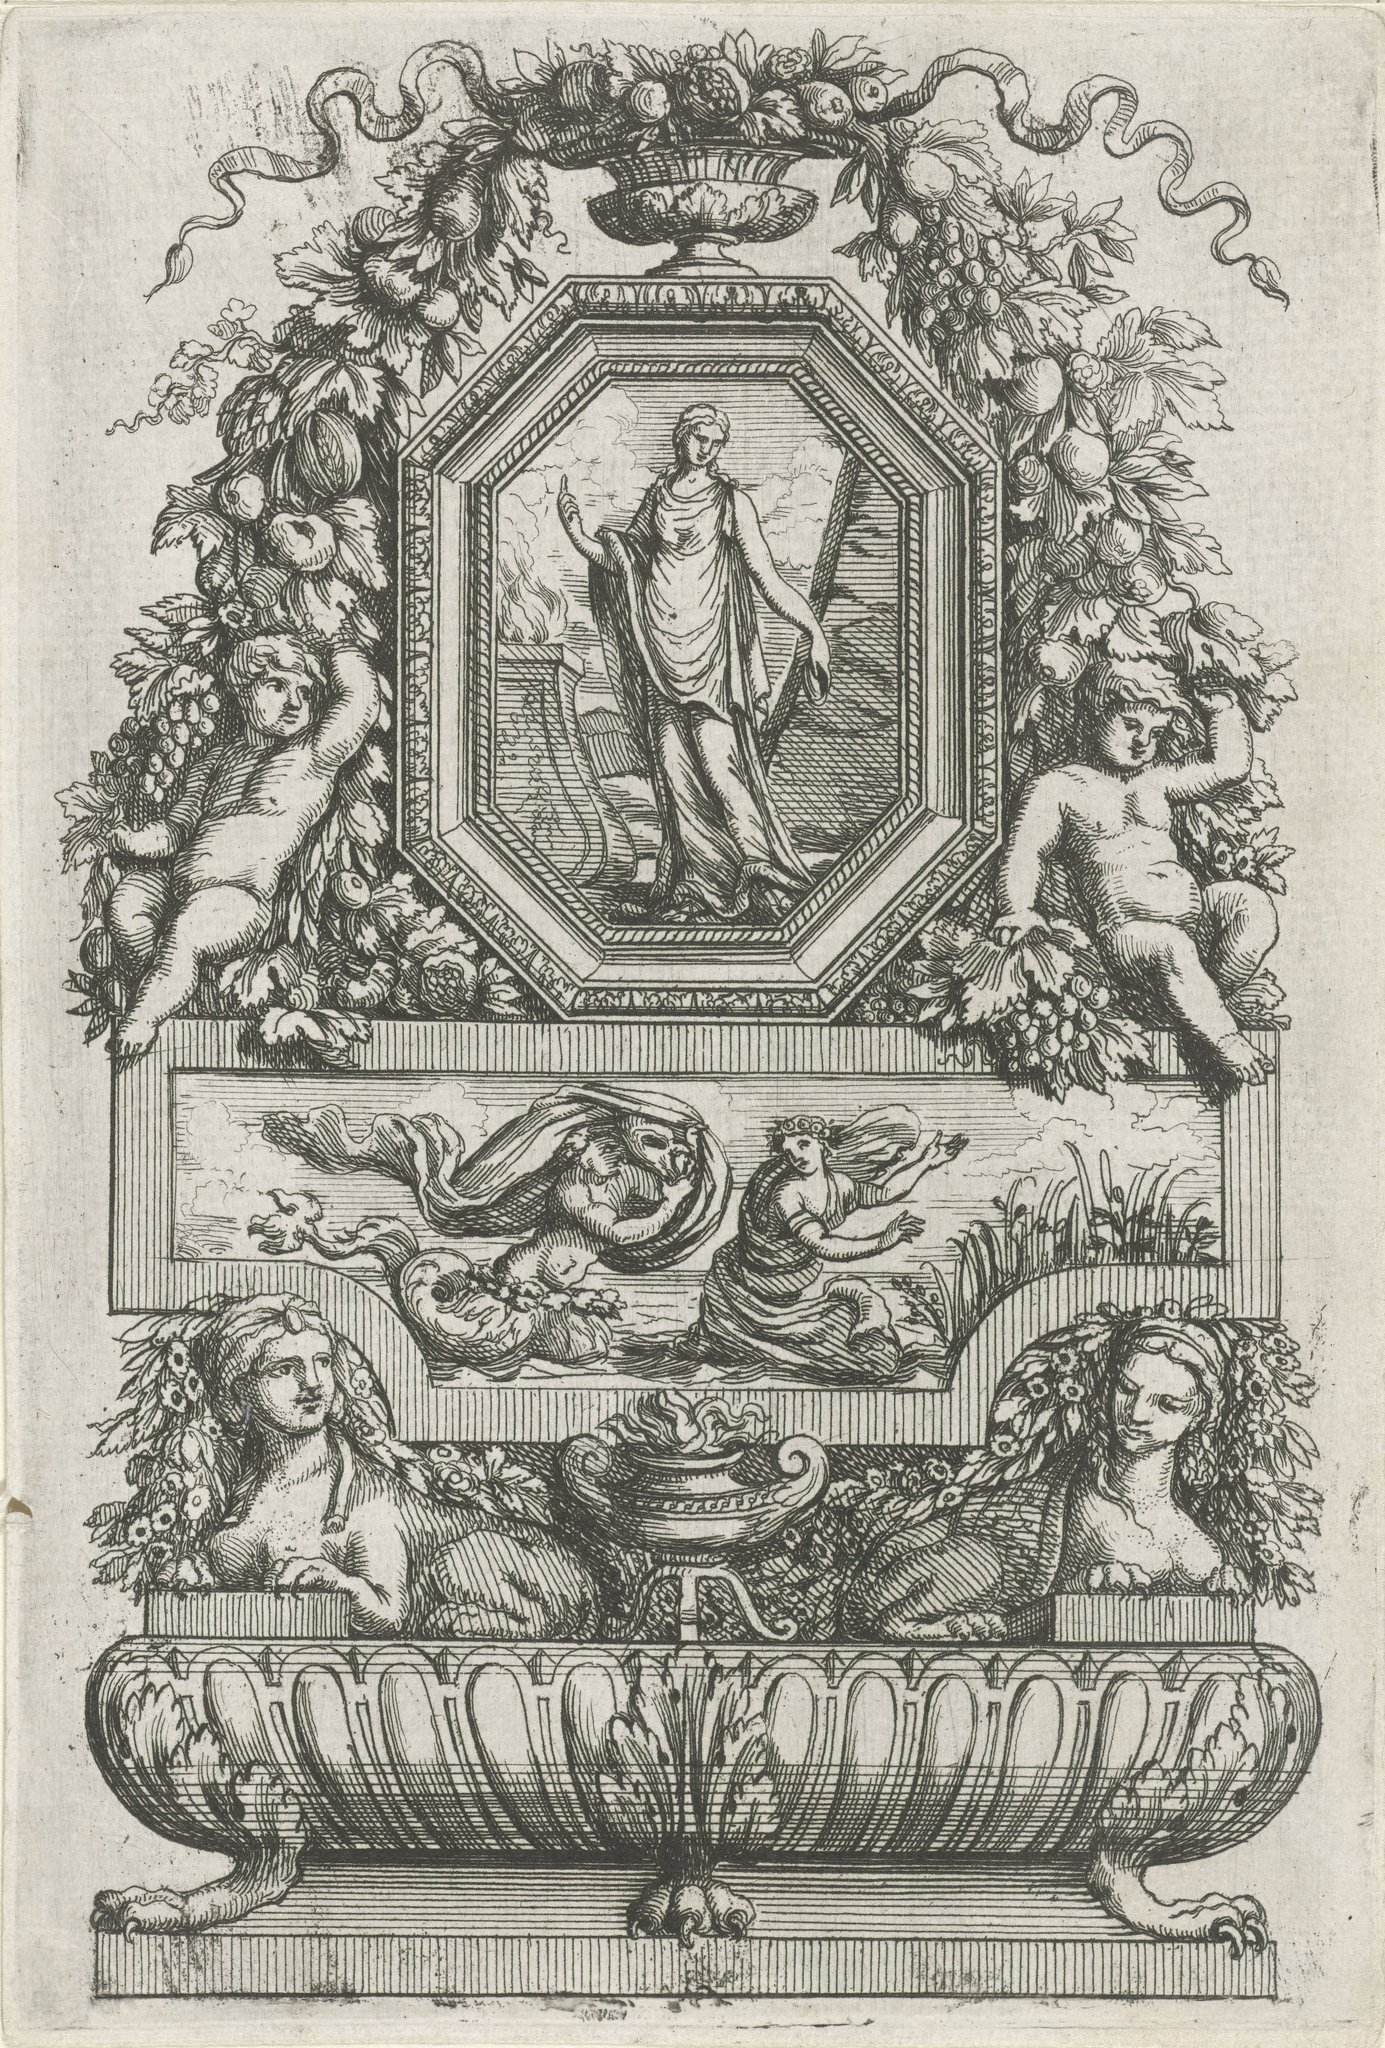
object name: print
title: Livre de divers panneaux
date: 1661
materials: paper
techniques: engraving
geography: paris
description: Bovenaan staat een vrouw in een achthoekige lijst afgebeeld. Uit serie van 12 bladen met ornamentele panelen opgebouwd uit medaillons, tabletten, friezen, sarcofagen, vazen, schilden, guirlandes, klimplanten en putti, geplaatst langs een verticale as. Uit eerste editie.